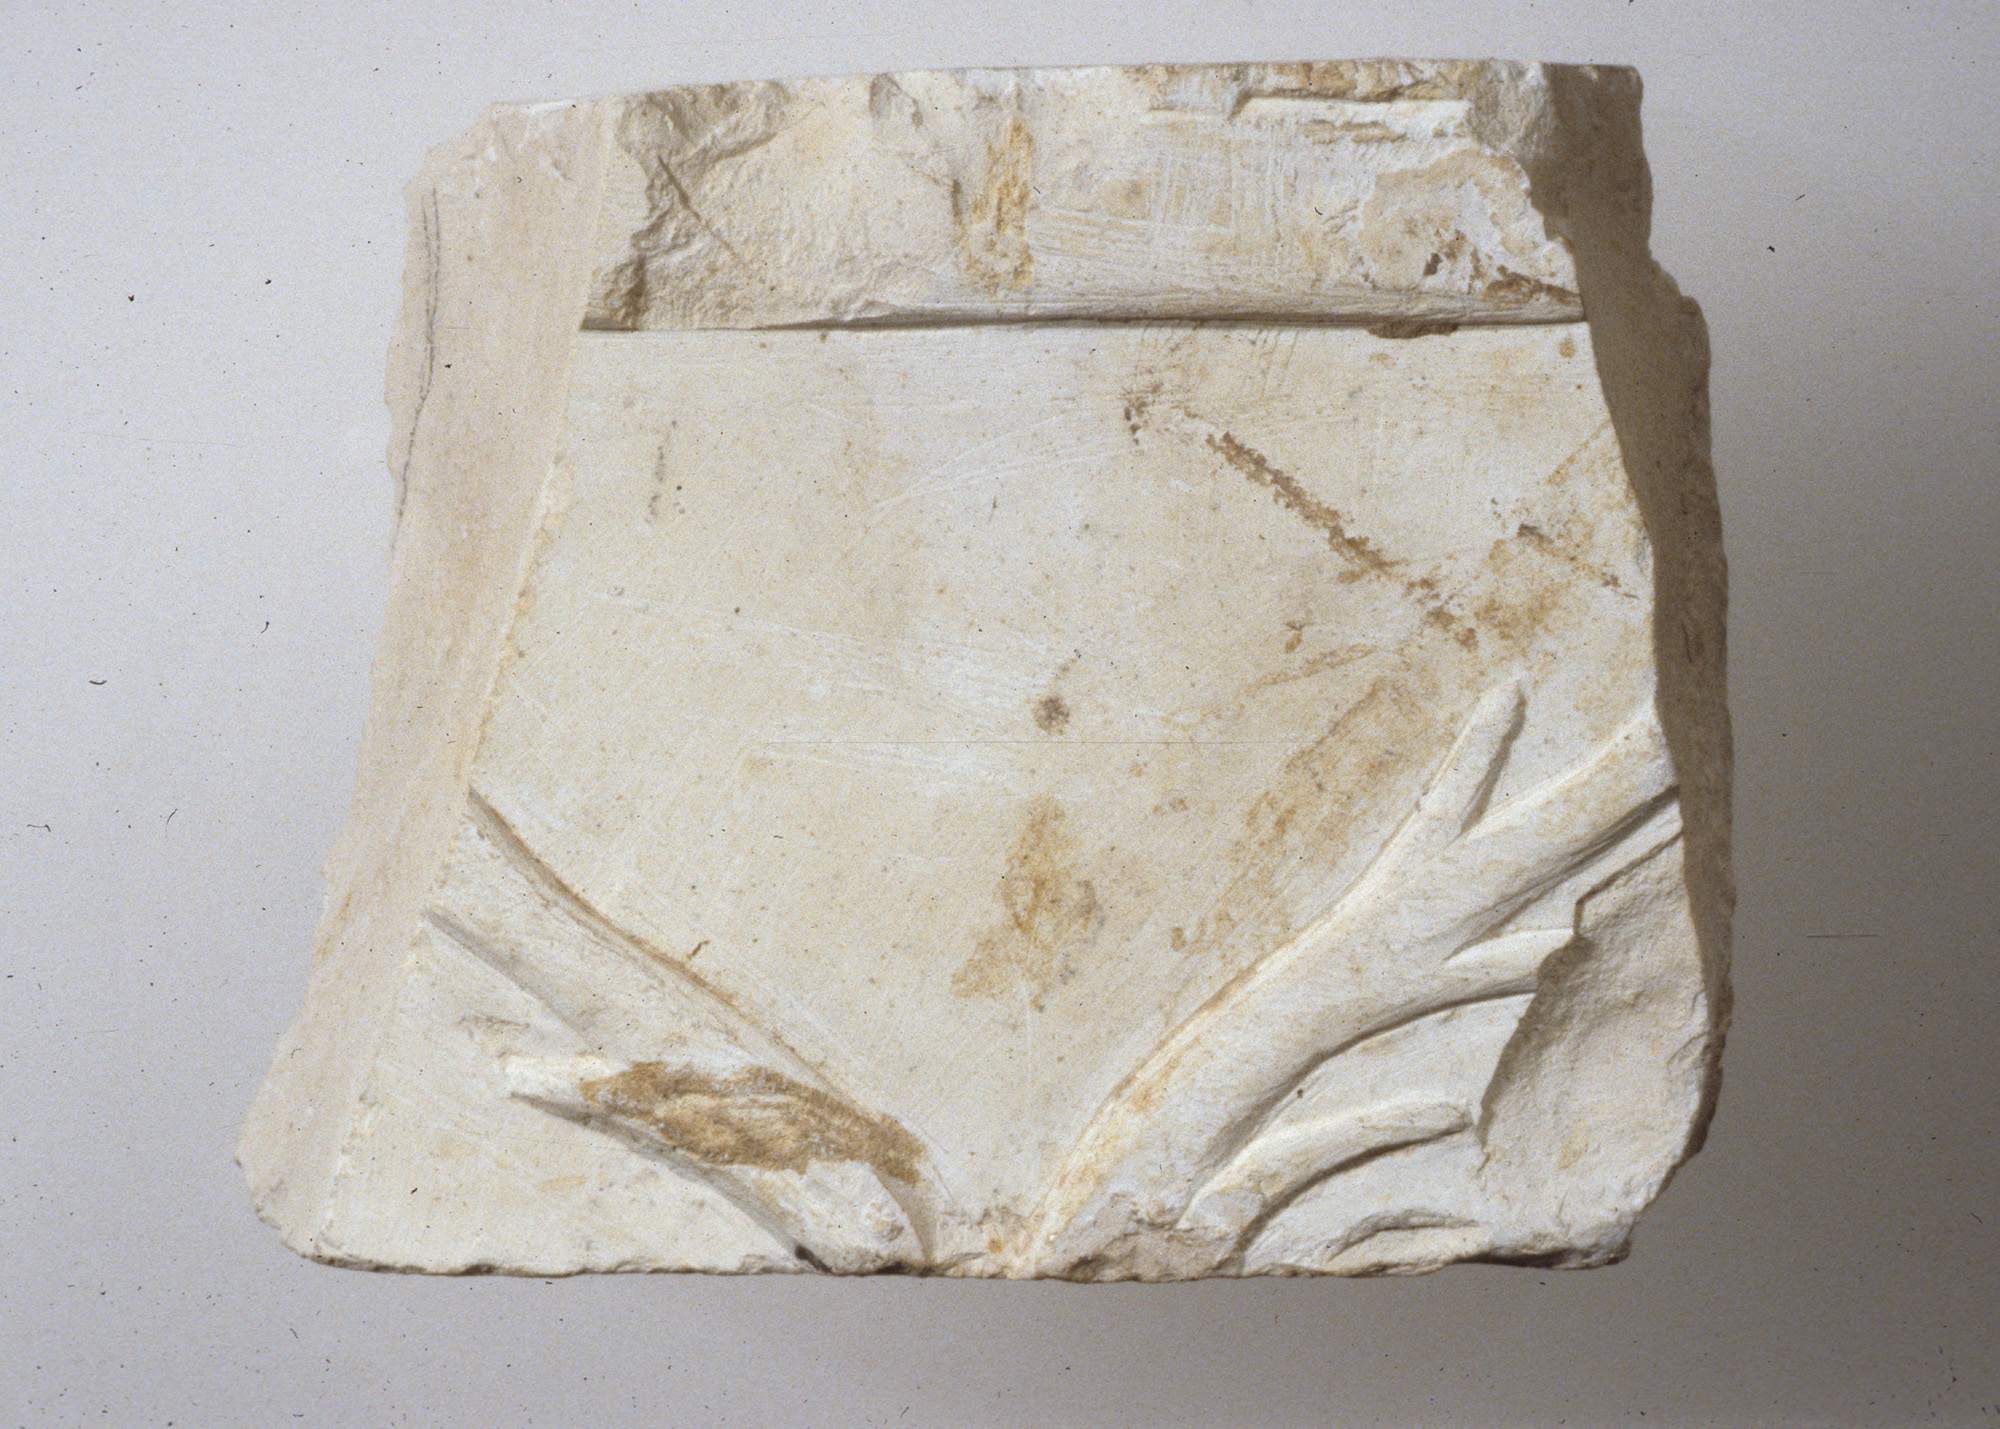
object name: relief fragment, tomb of meketre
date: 1981-1975 BCE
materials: limestone, paint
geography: egypt